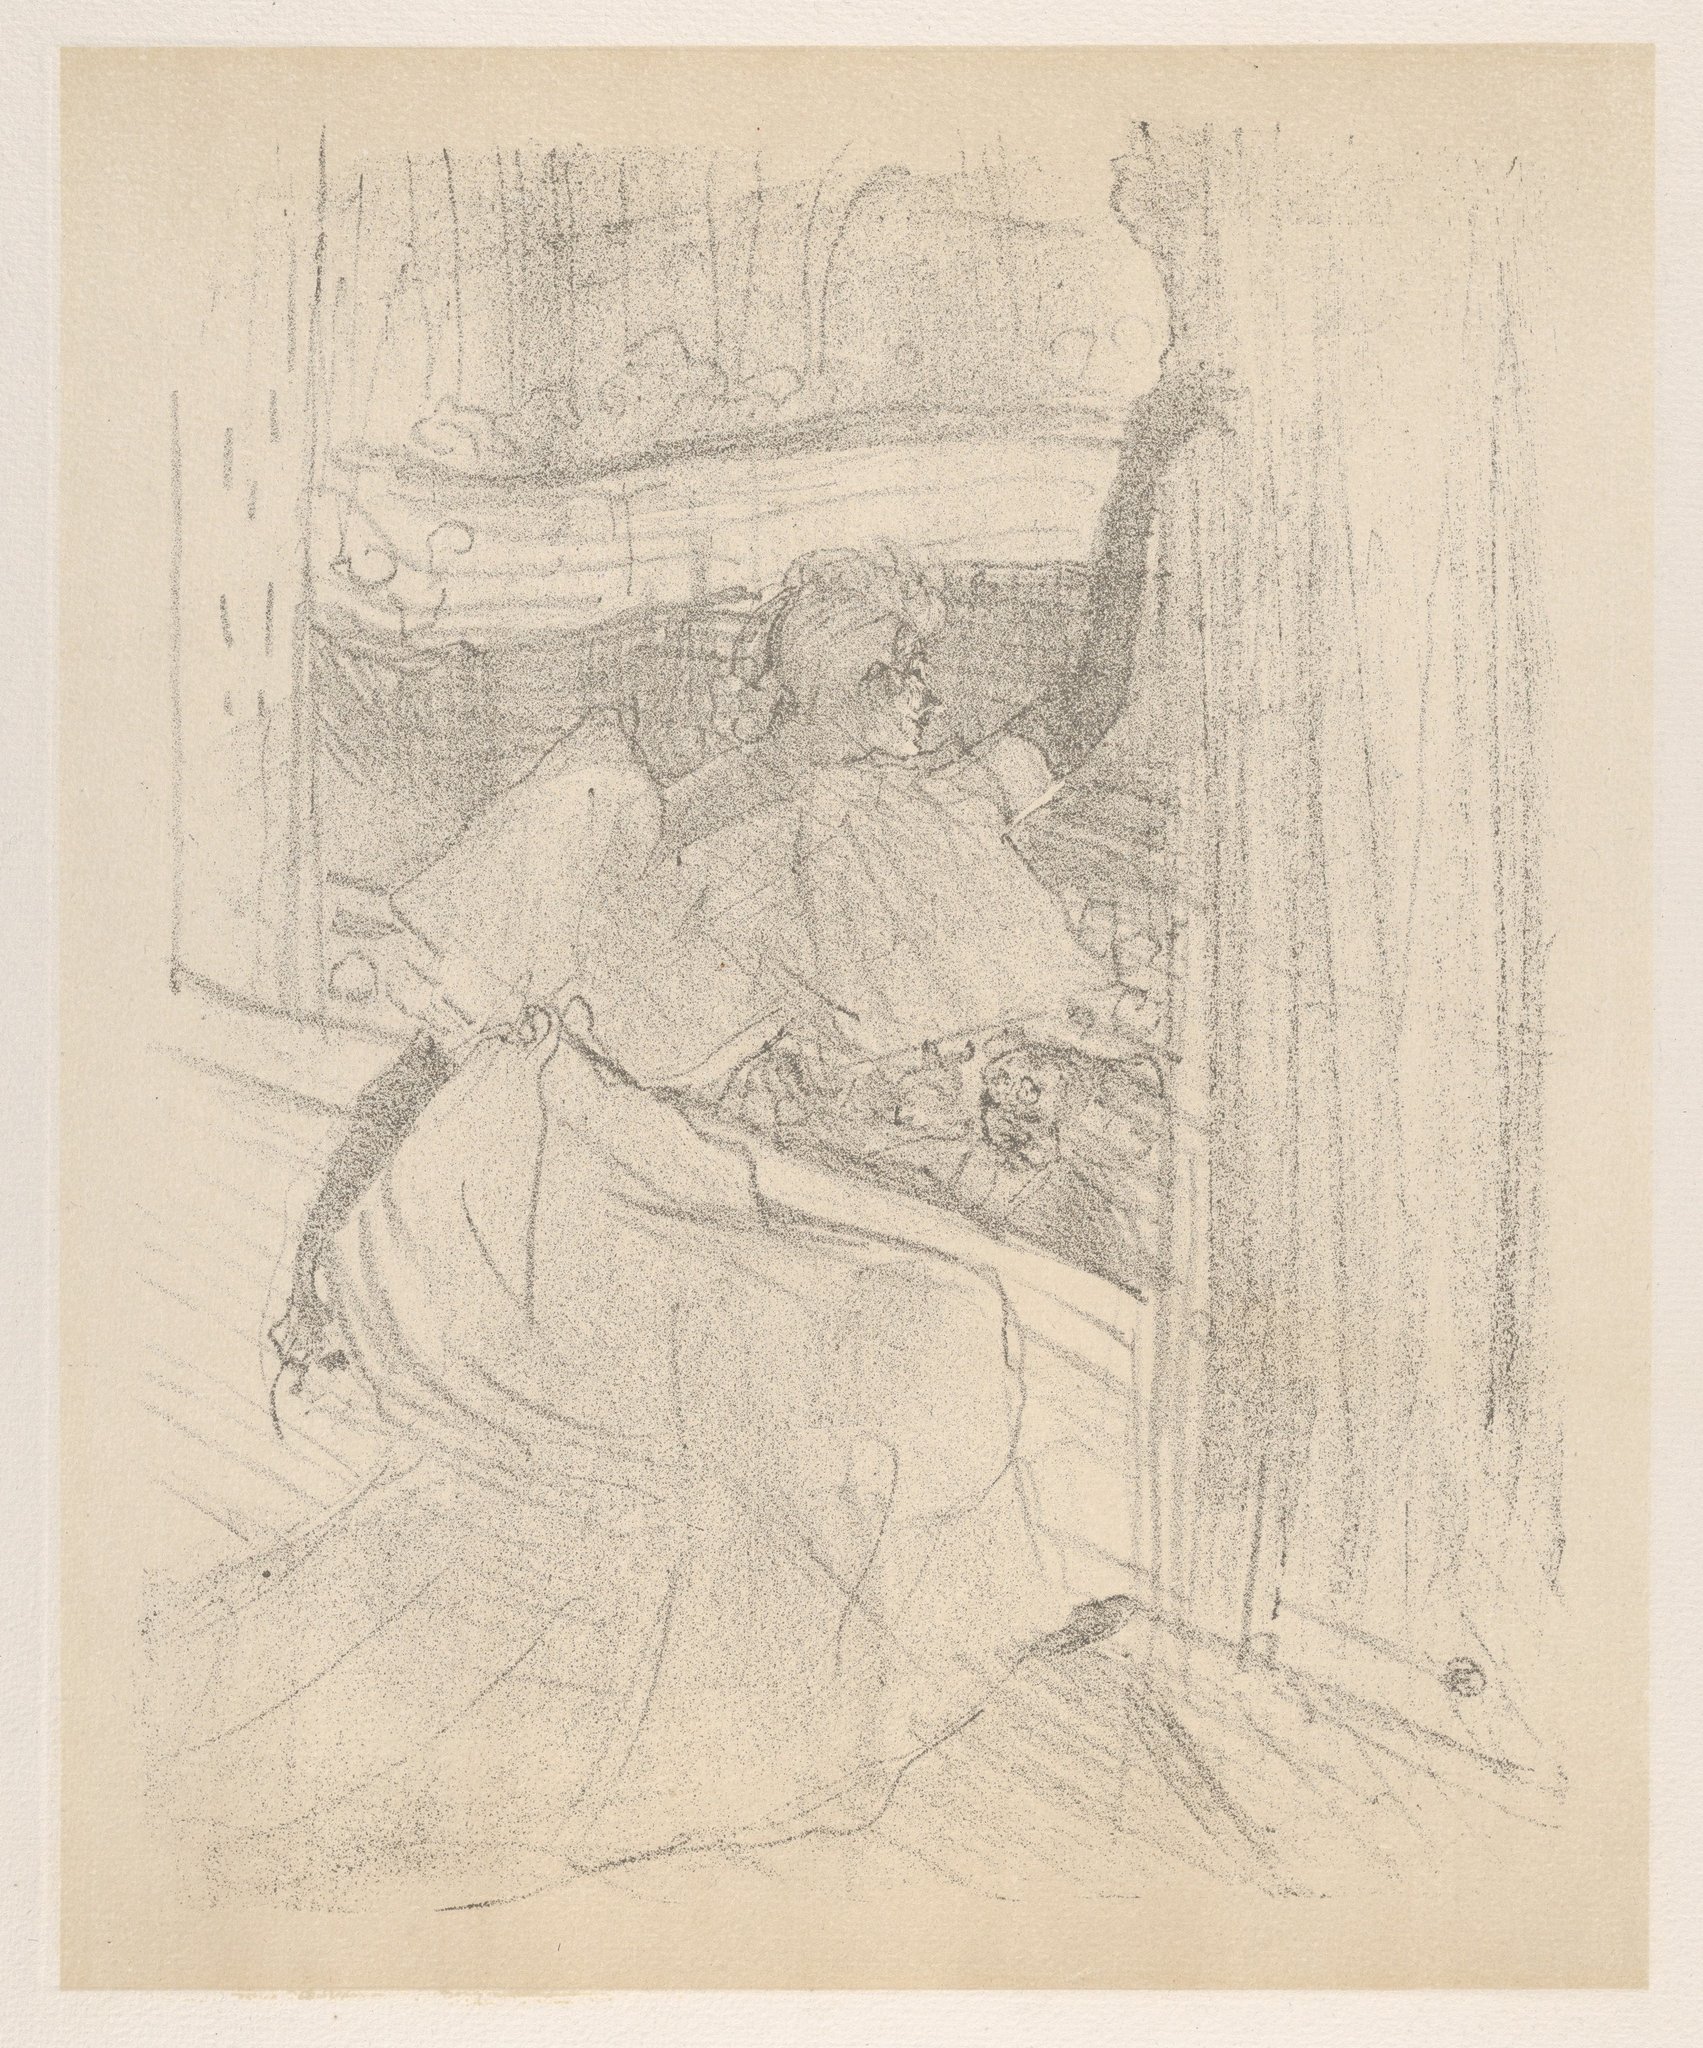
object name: print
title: VIII. Saluant le Public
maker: henri de toulouse-lautrec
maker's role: artist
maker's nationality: french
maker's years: 1864-1901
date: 1898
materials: paper, stone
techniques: lithograph, printing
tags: women